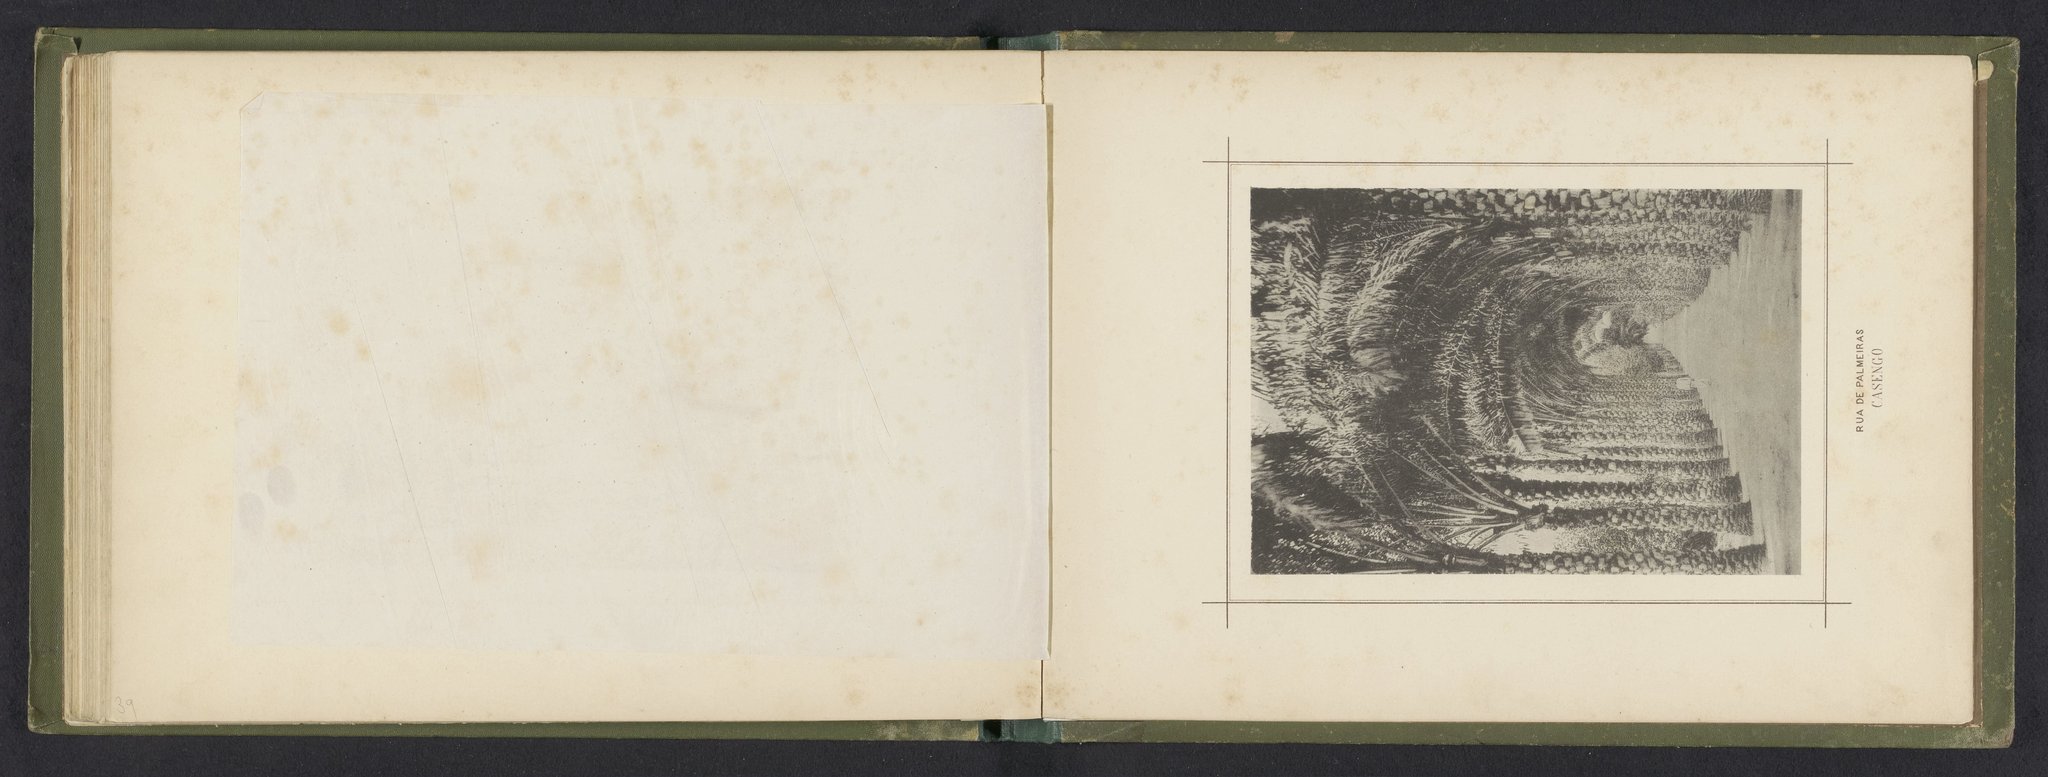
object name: page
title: Rua de palmeiras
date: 1876-1886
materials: paper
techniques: photograph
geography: angola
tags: trees: palm-tree, lane, alley